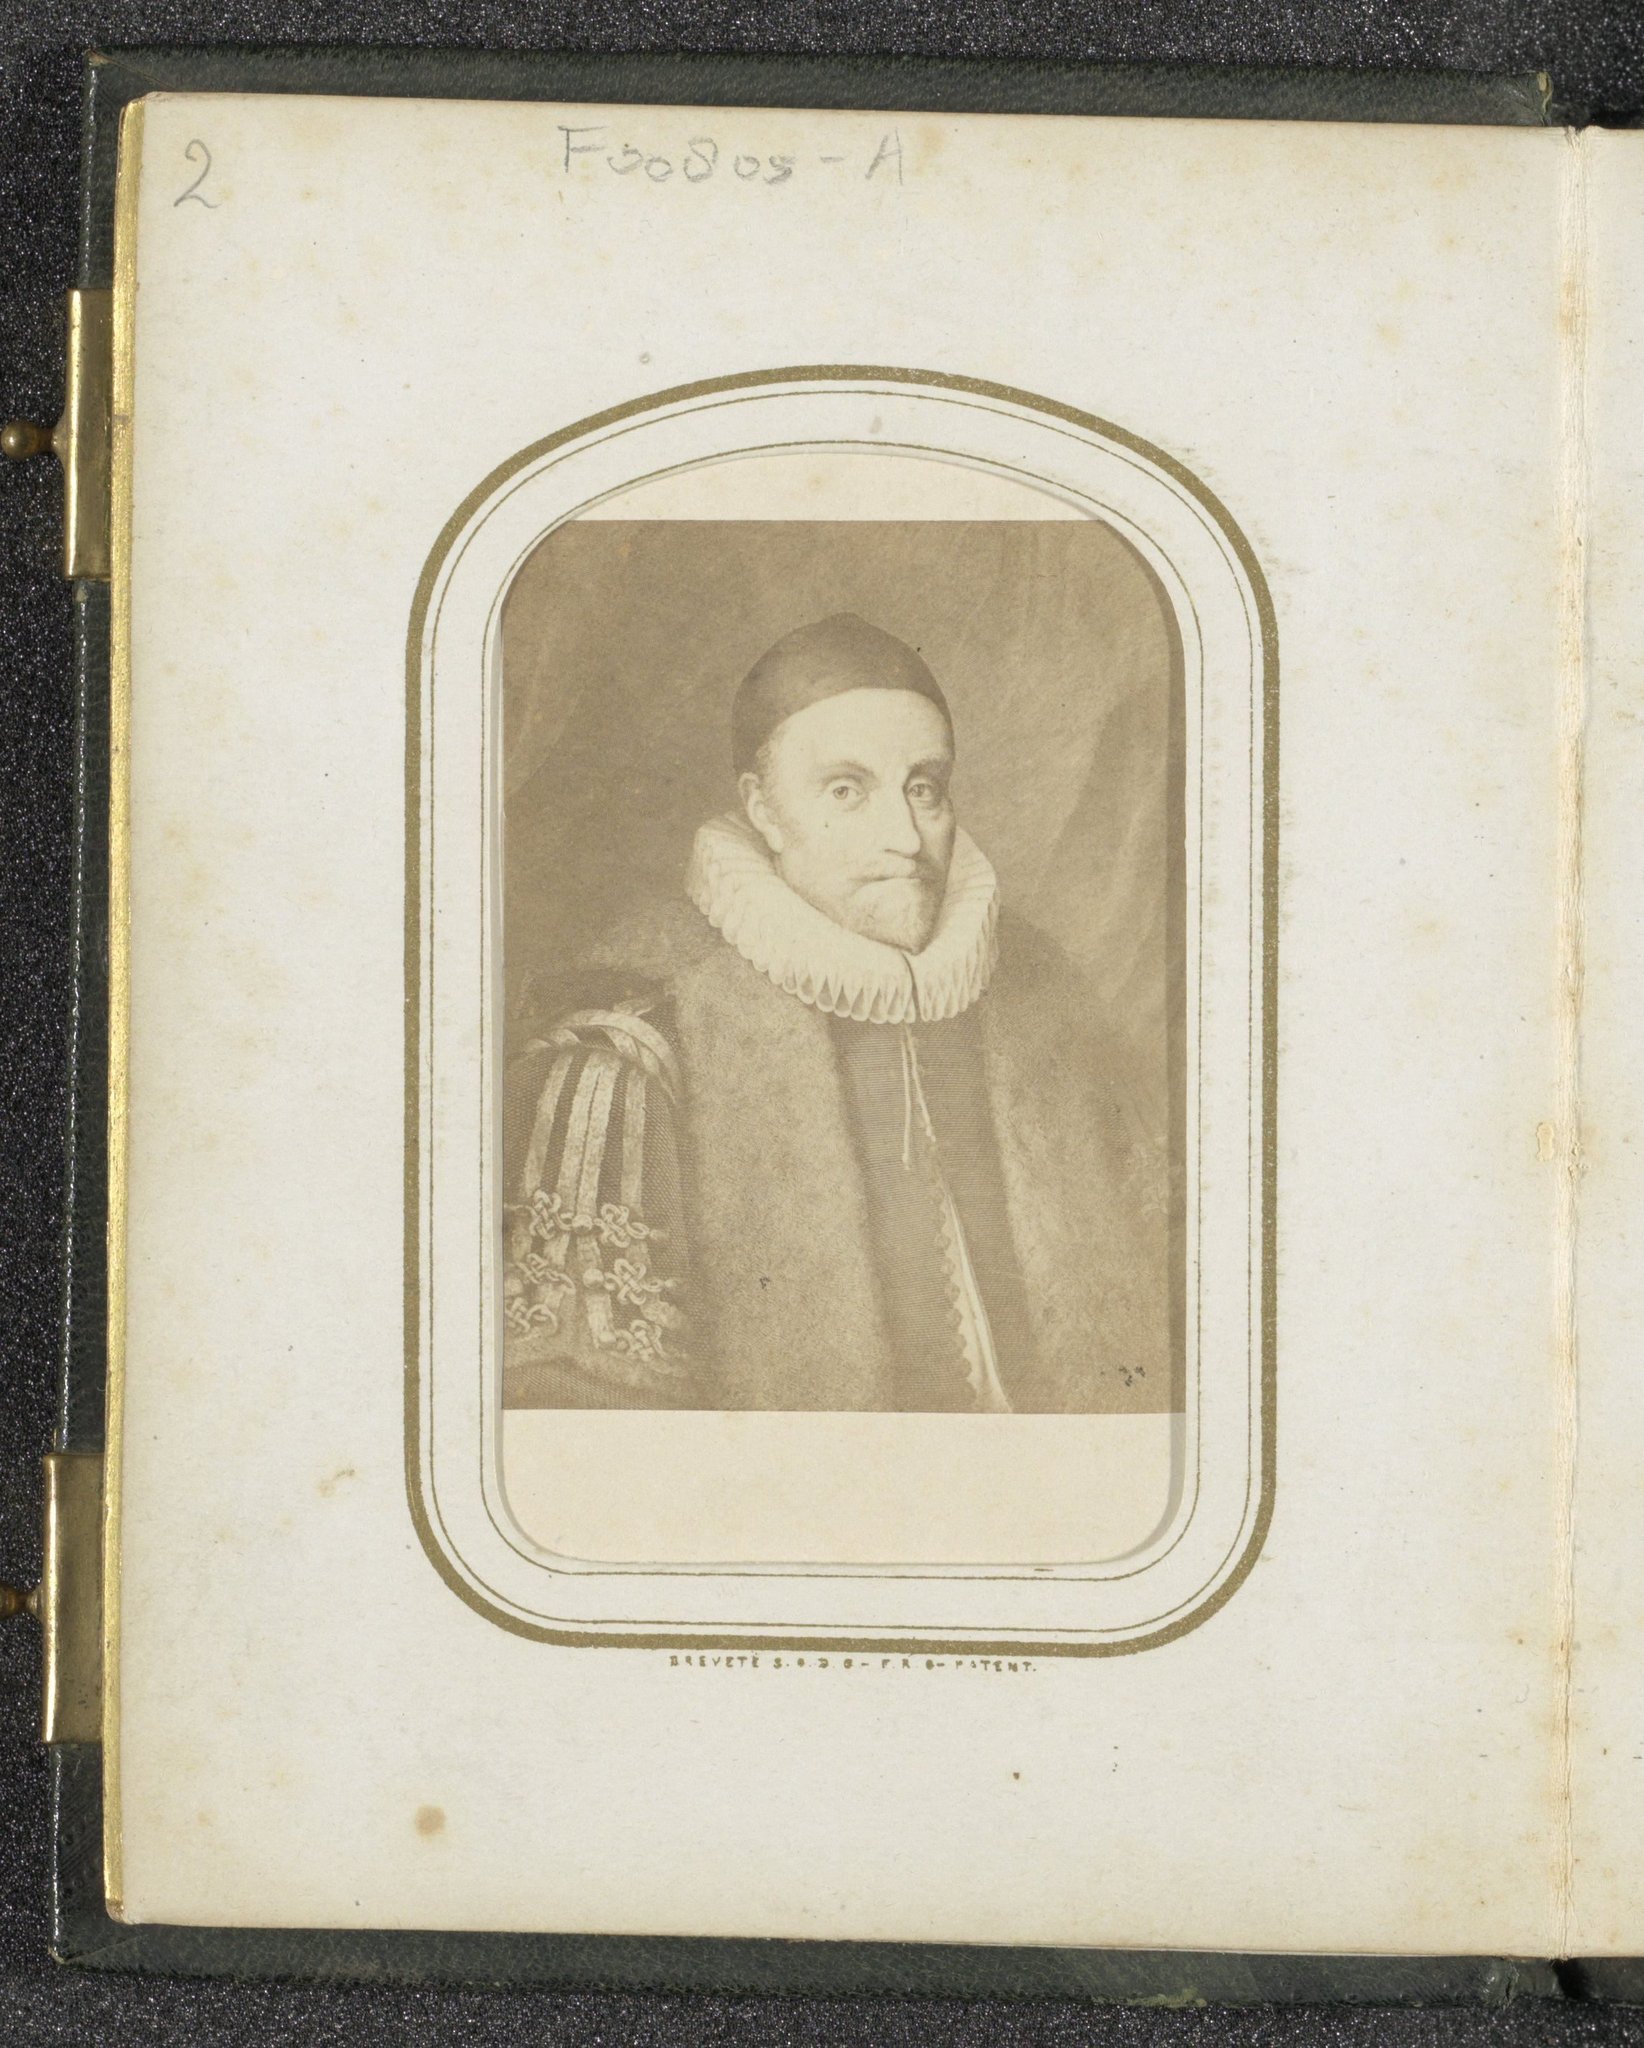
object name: reproduction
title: Fotoreproductie van (vermoedelijk) een prent van Willem I, prins van Oranje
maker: andries jager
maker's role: publisher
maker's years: 1825-1905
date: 1860-1880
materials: cardboard, paper, photographic support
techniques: albumen print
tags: william i (prince of orange), coat (+ fur used for clothes), prince, historical persons, clothing for the upper part of the body, head-gear: cap, stadtholder, neck-gear: collar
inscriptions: address: ‘Water 110 Amsterdam’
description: Onderdeel van Fotoalbum met 29 foto's van Nederlandse vorsten.